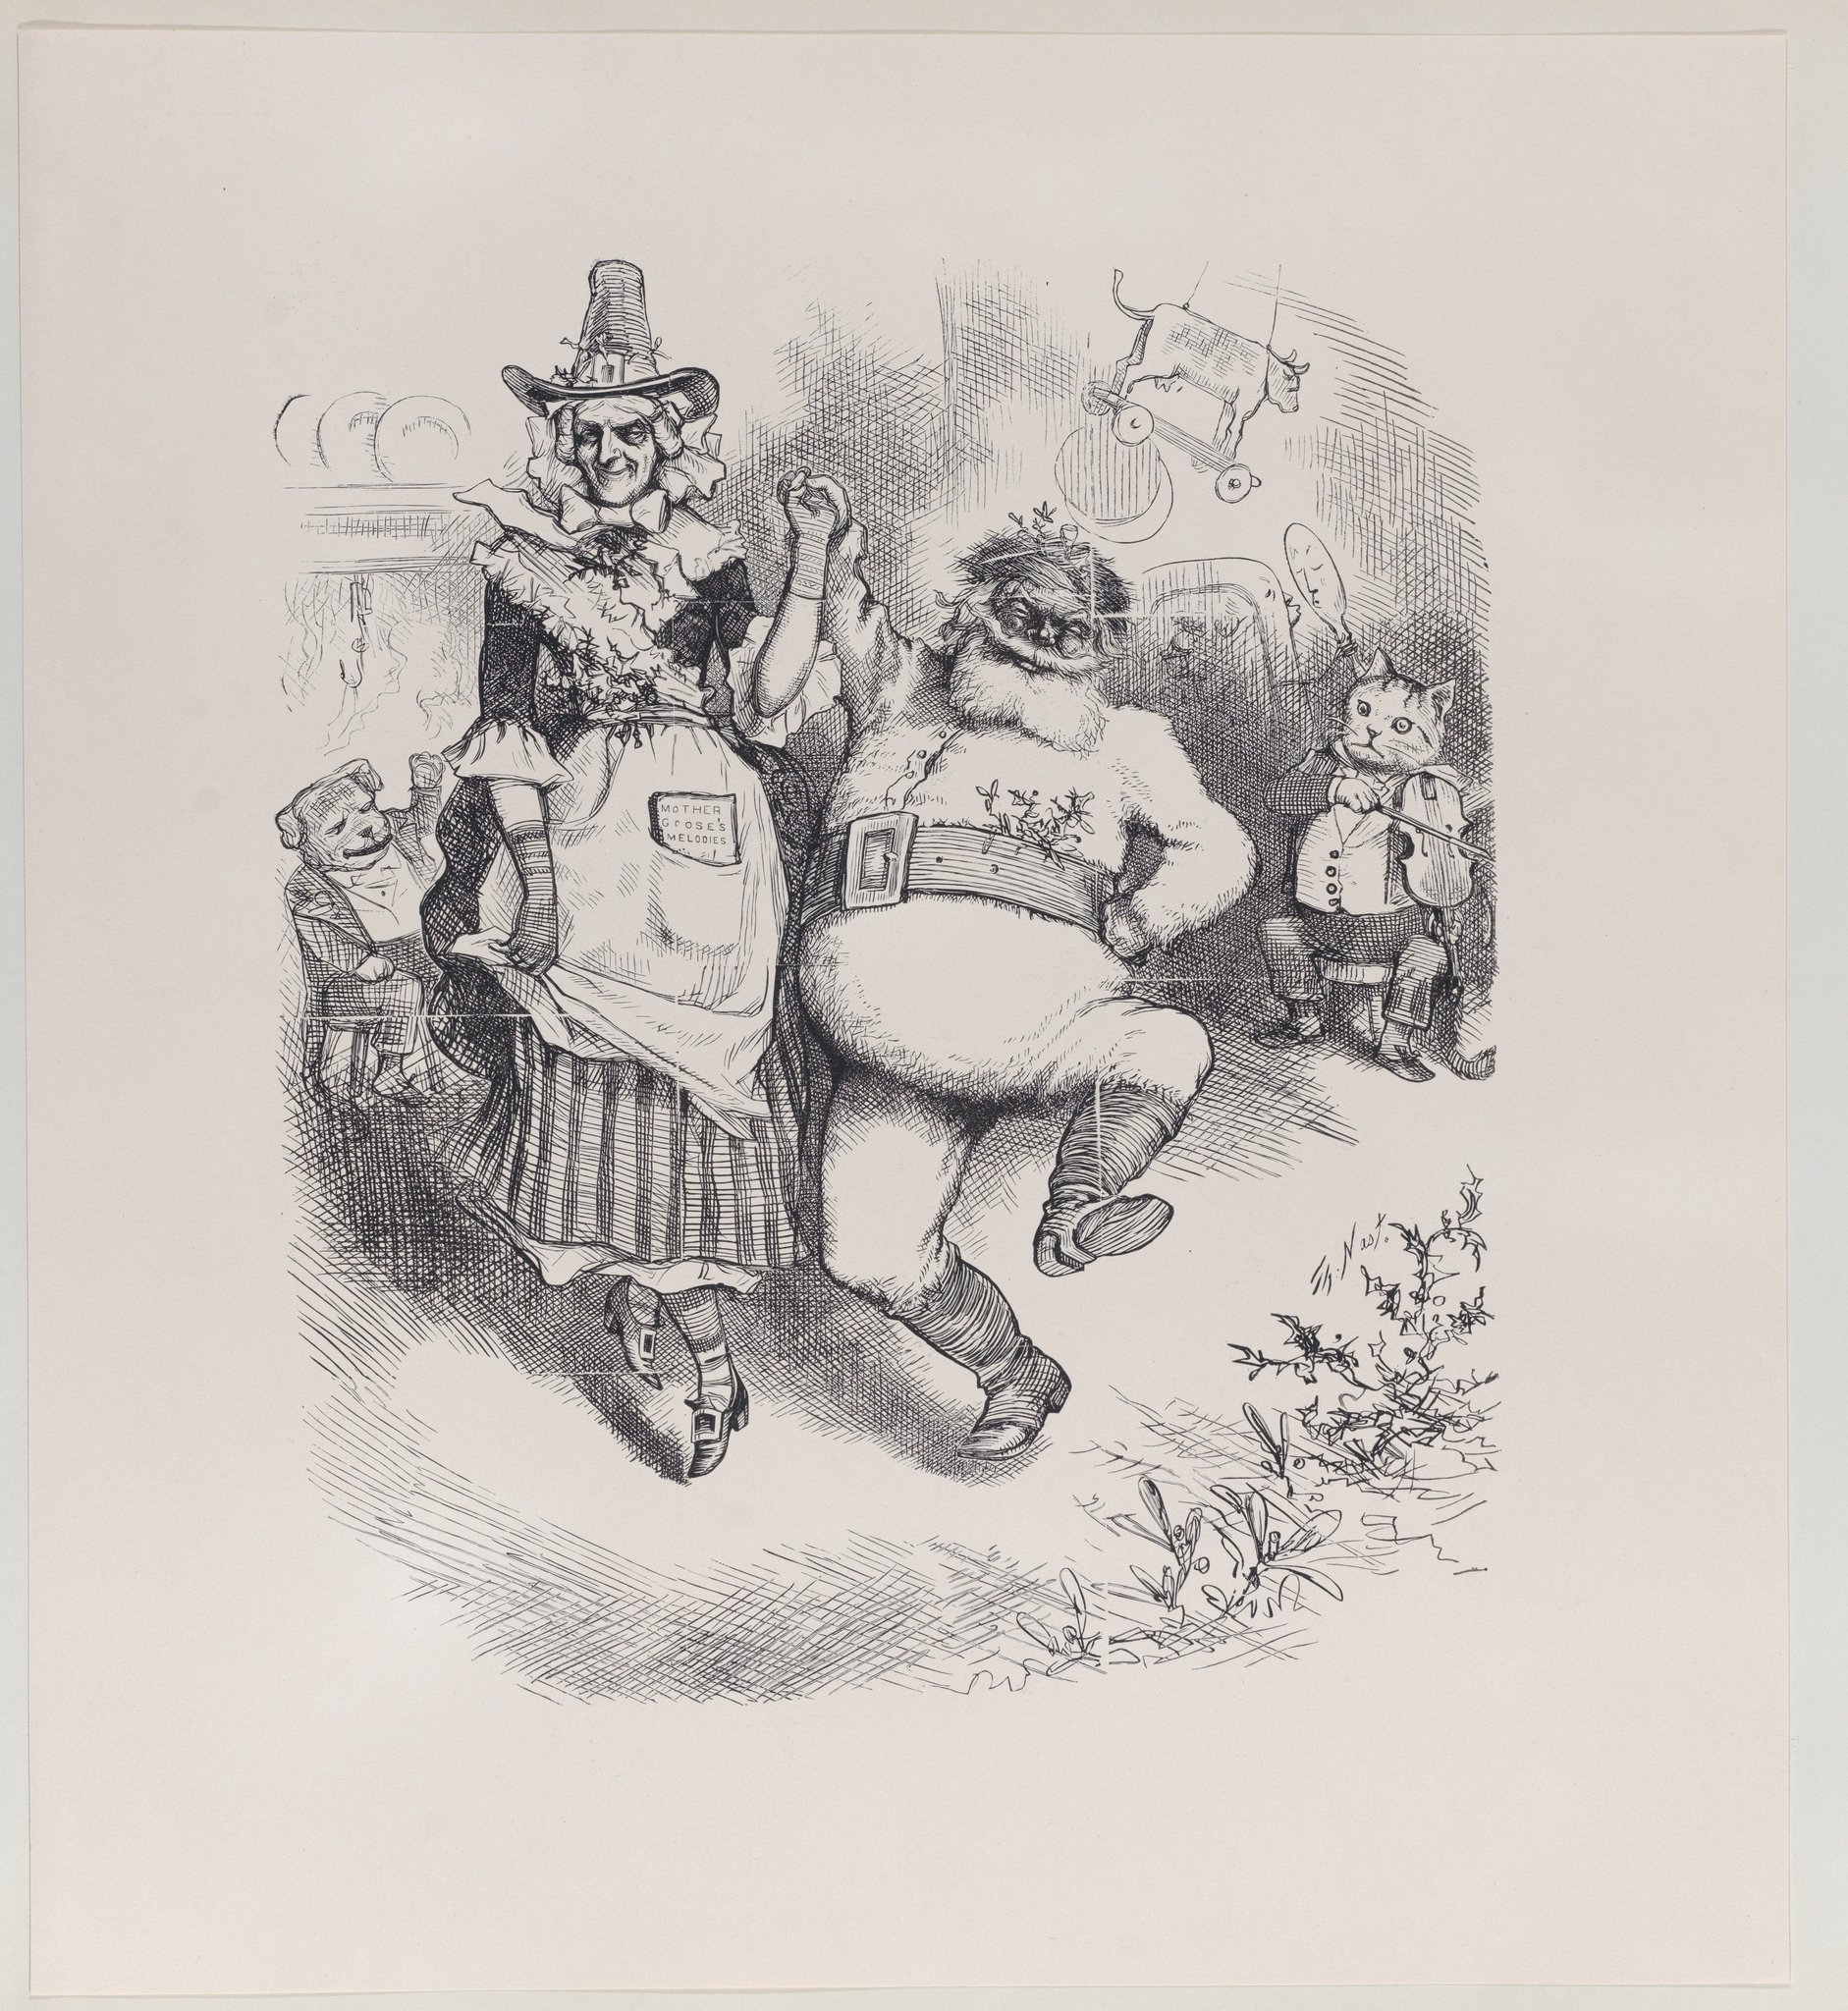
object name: print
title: A Merry Christmas (published in "Harper's Weekly," January 3, 1880)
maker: thomas nast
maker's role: artist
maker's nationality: american, born germany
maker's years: 1840-1902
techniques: relief print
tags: men,women,violins,cats,dogs,christmas,santa claus